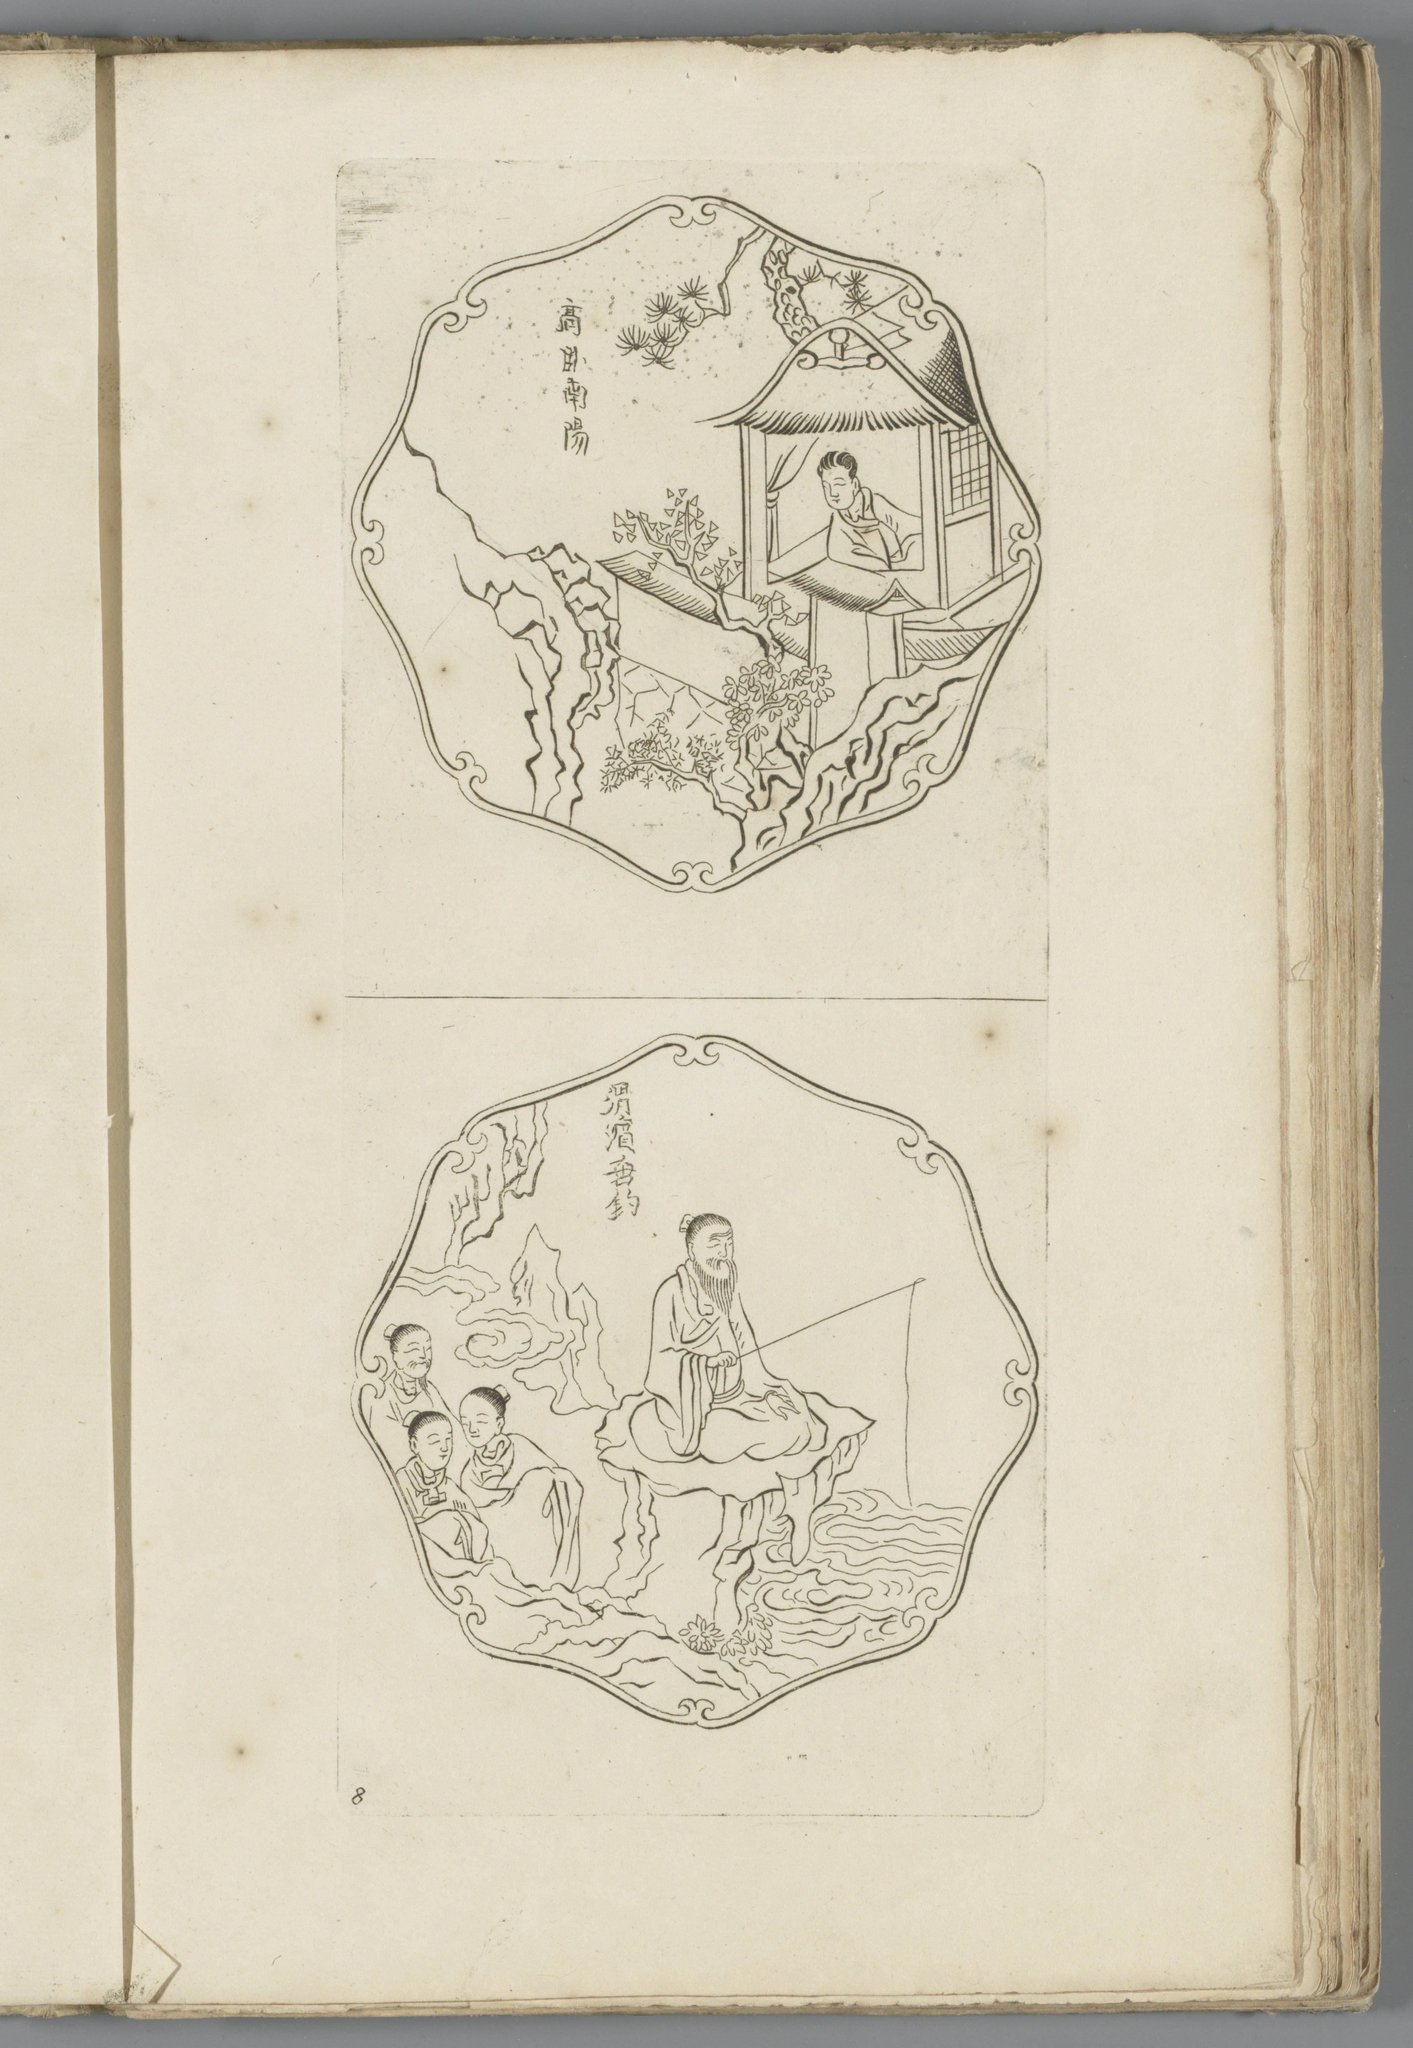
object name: album leaf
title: Picturae Sinicae Ac Surattenae, Vasis Tabellisque exhibitae, Admiranda; colligente Petro Schenkio cum privil: Amstelaed: 1702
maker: pieter schenk (i)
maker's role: print maker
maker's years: 1660-1711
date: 1702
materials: paper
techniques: etching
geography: amsterdam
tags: chinese, angling